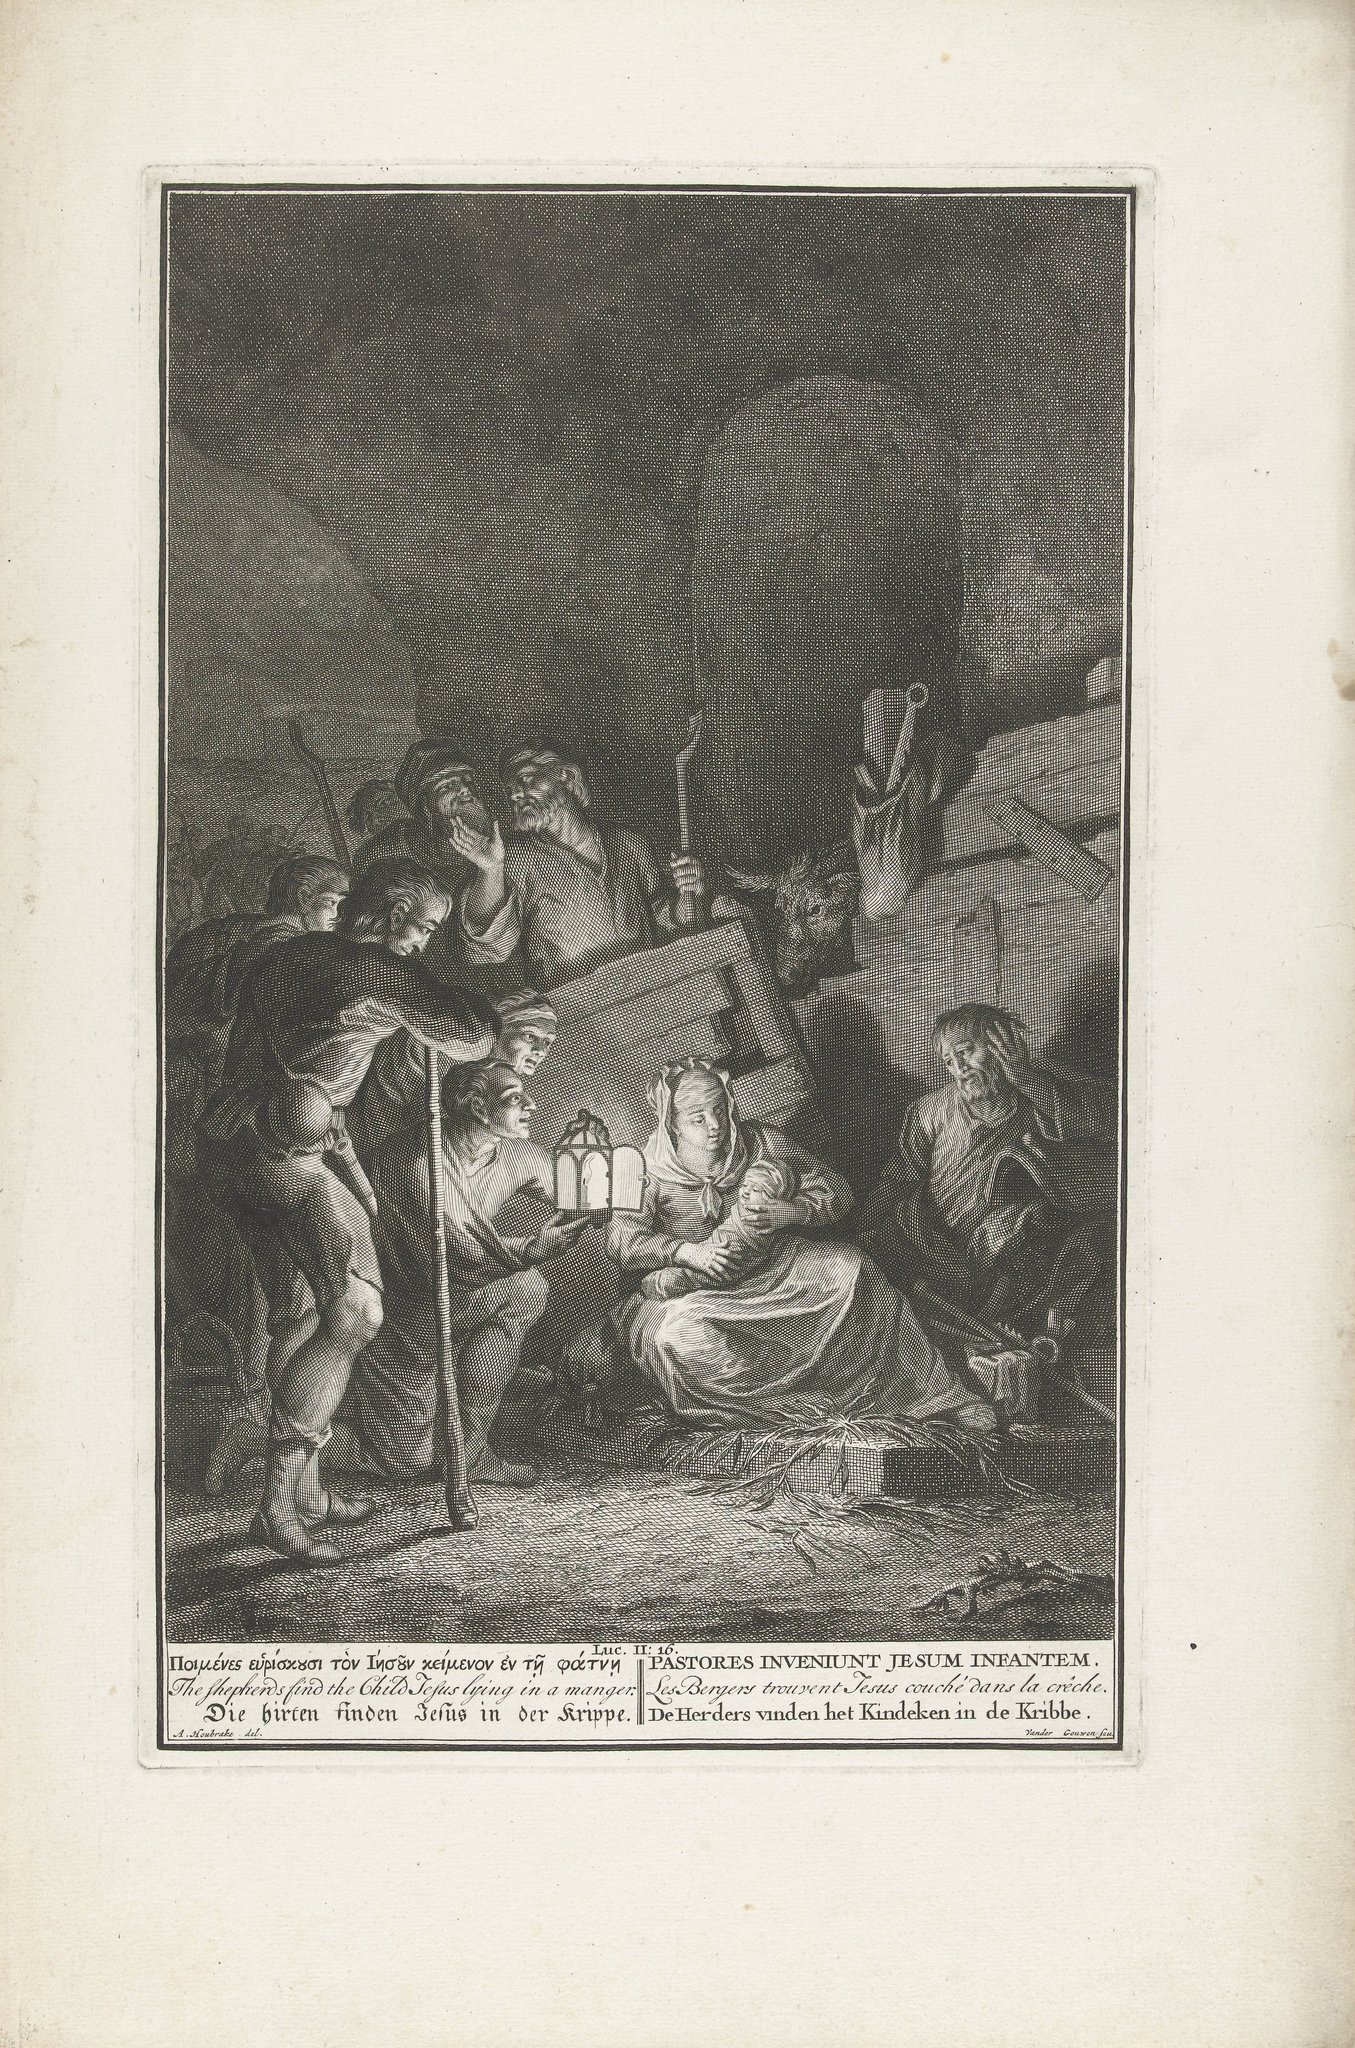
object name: print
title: Aanbidding der herders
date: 1728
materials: paper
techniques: engraving, etching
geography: the hague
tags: adoration of the christ-child by the shepherds; mary and joseph present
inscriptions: inscription: ‘utrechts Fundatie huijs’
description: De herders vinden Maria en Jozef in een stal. Ze knielen voor het Christuskind (Luc. 2:16). De prent heeft een Grieks, Latijns, Frans, Engels, Duits en Nederlands onderschrift.